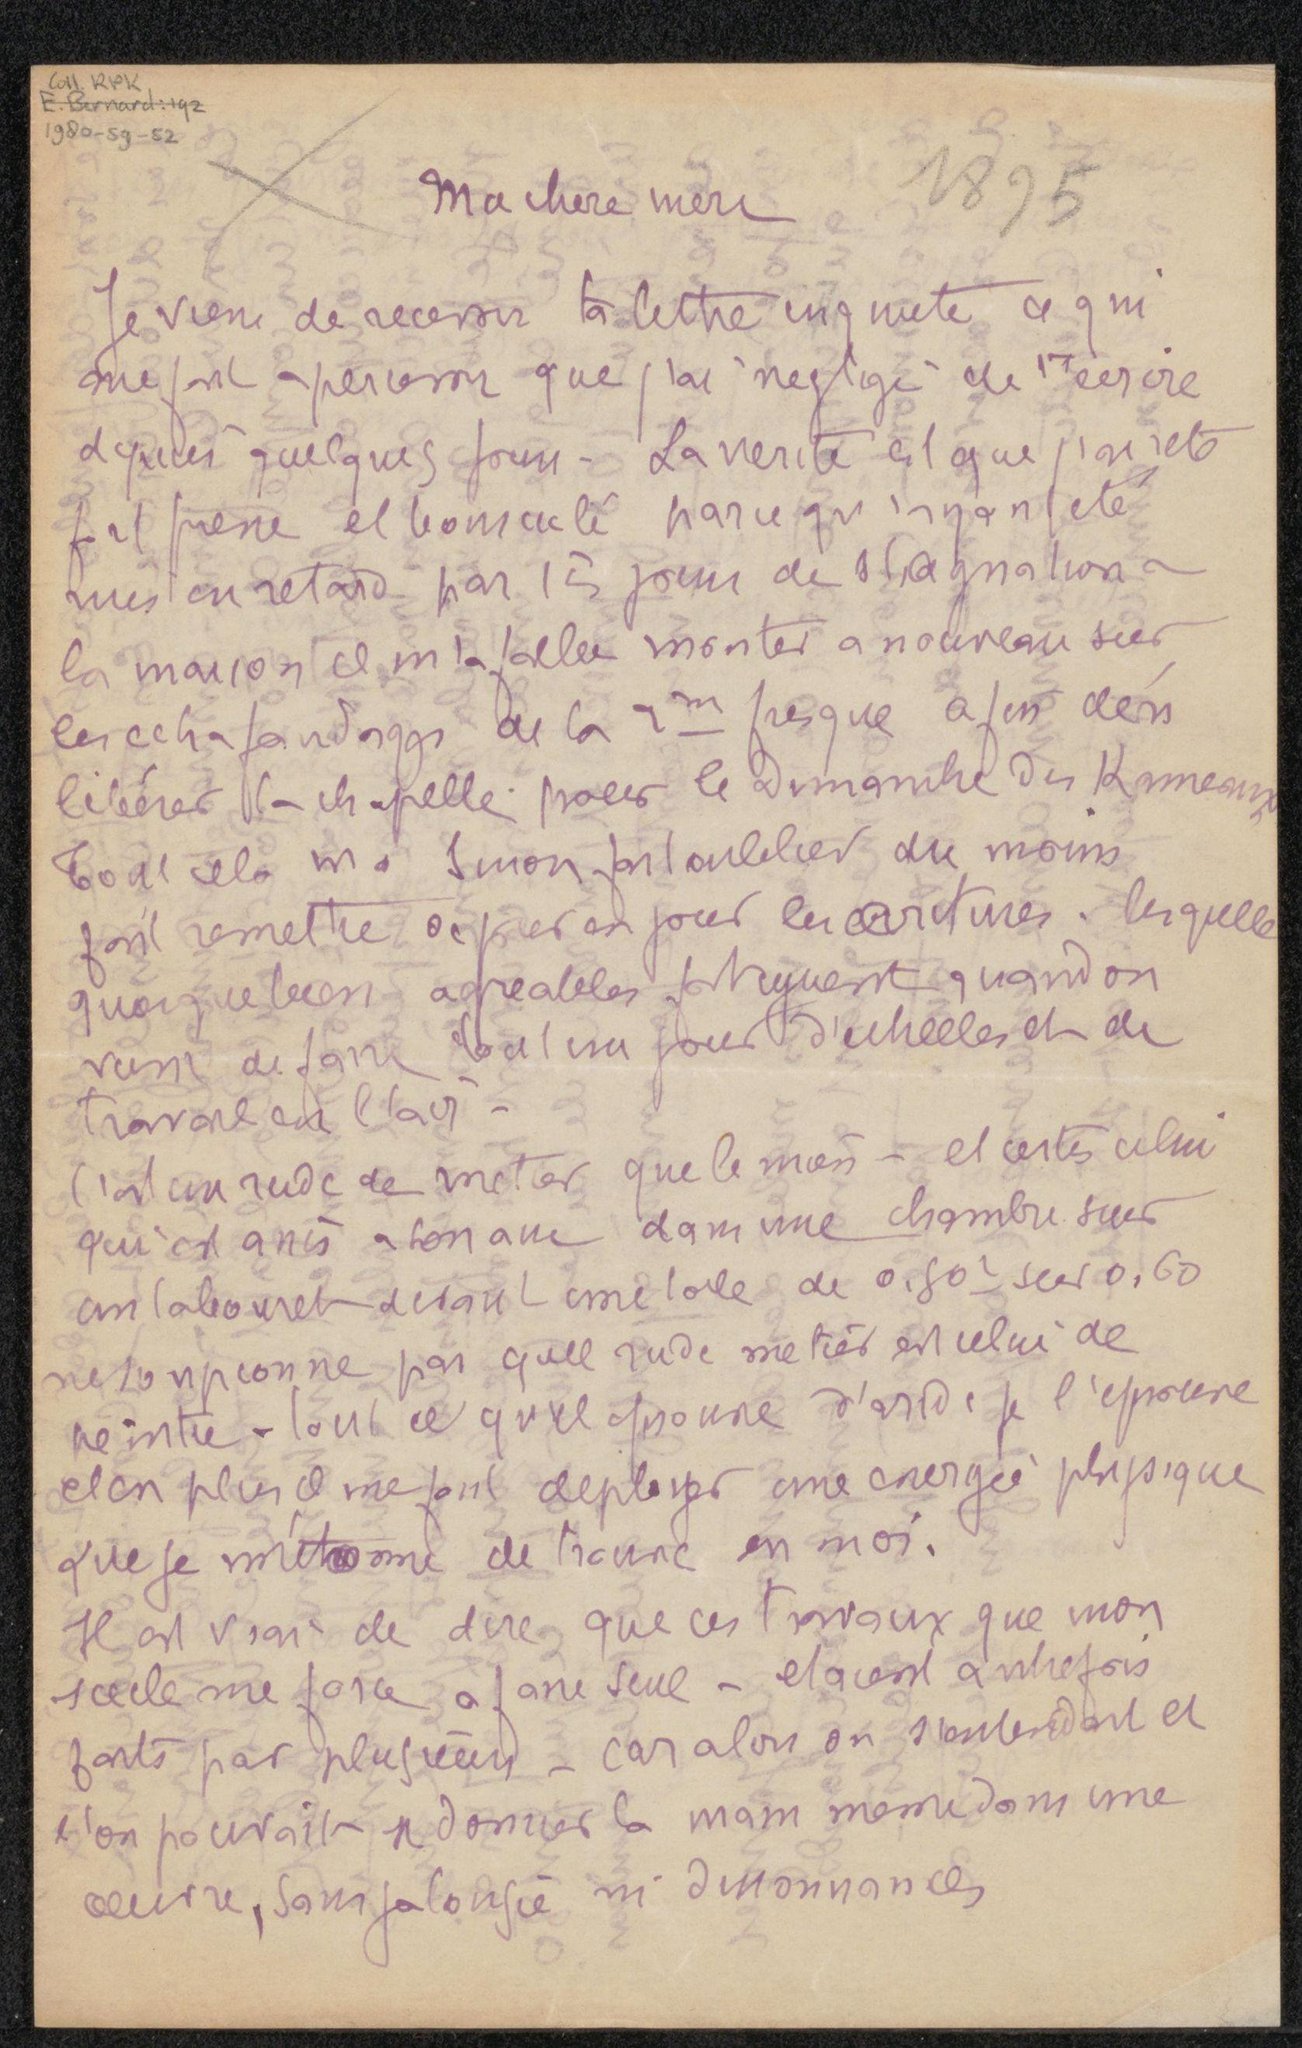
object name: letter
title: Brief aan Héloïse Bernard-Bodin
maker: émile bernard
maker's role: print maker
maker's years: 1868-1941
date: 1878-1941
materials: ink, paper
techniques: pen, writing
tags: héloïse bernard-bodin